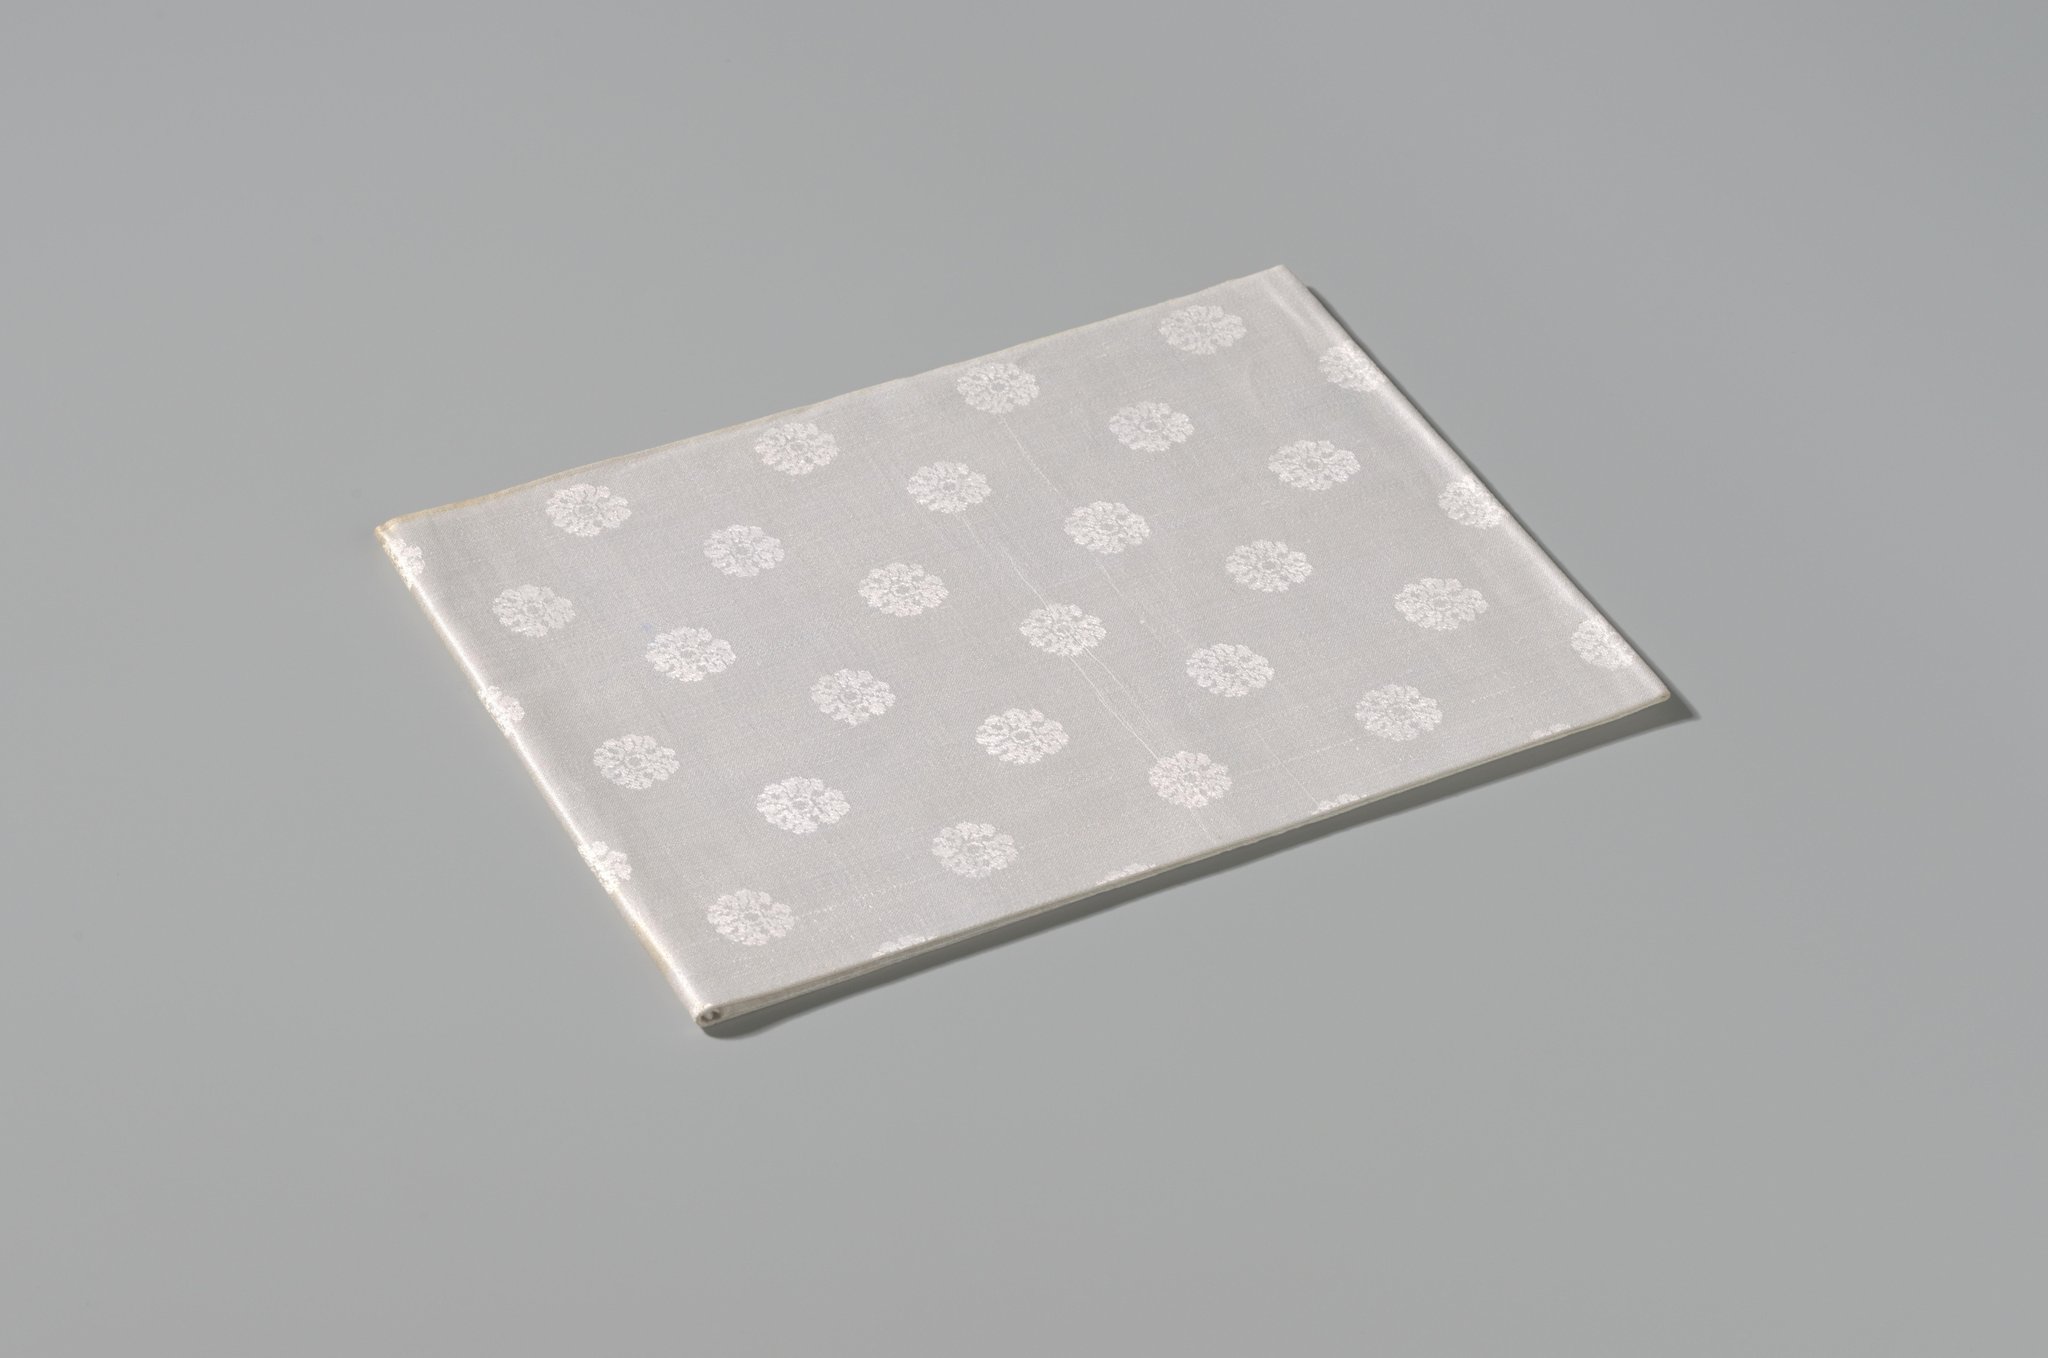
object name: napkin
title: Servet met patroon van rozetten en rozentakken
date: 1780-1800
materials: linen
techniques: damask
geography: northern netherlands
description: Wit linnendamasten servet met een patroon van rozetten en rozentakken, merk 100 en HW 30.